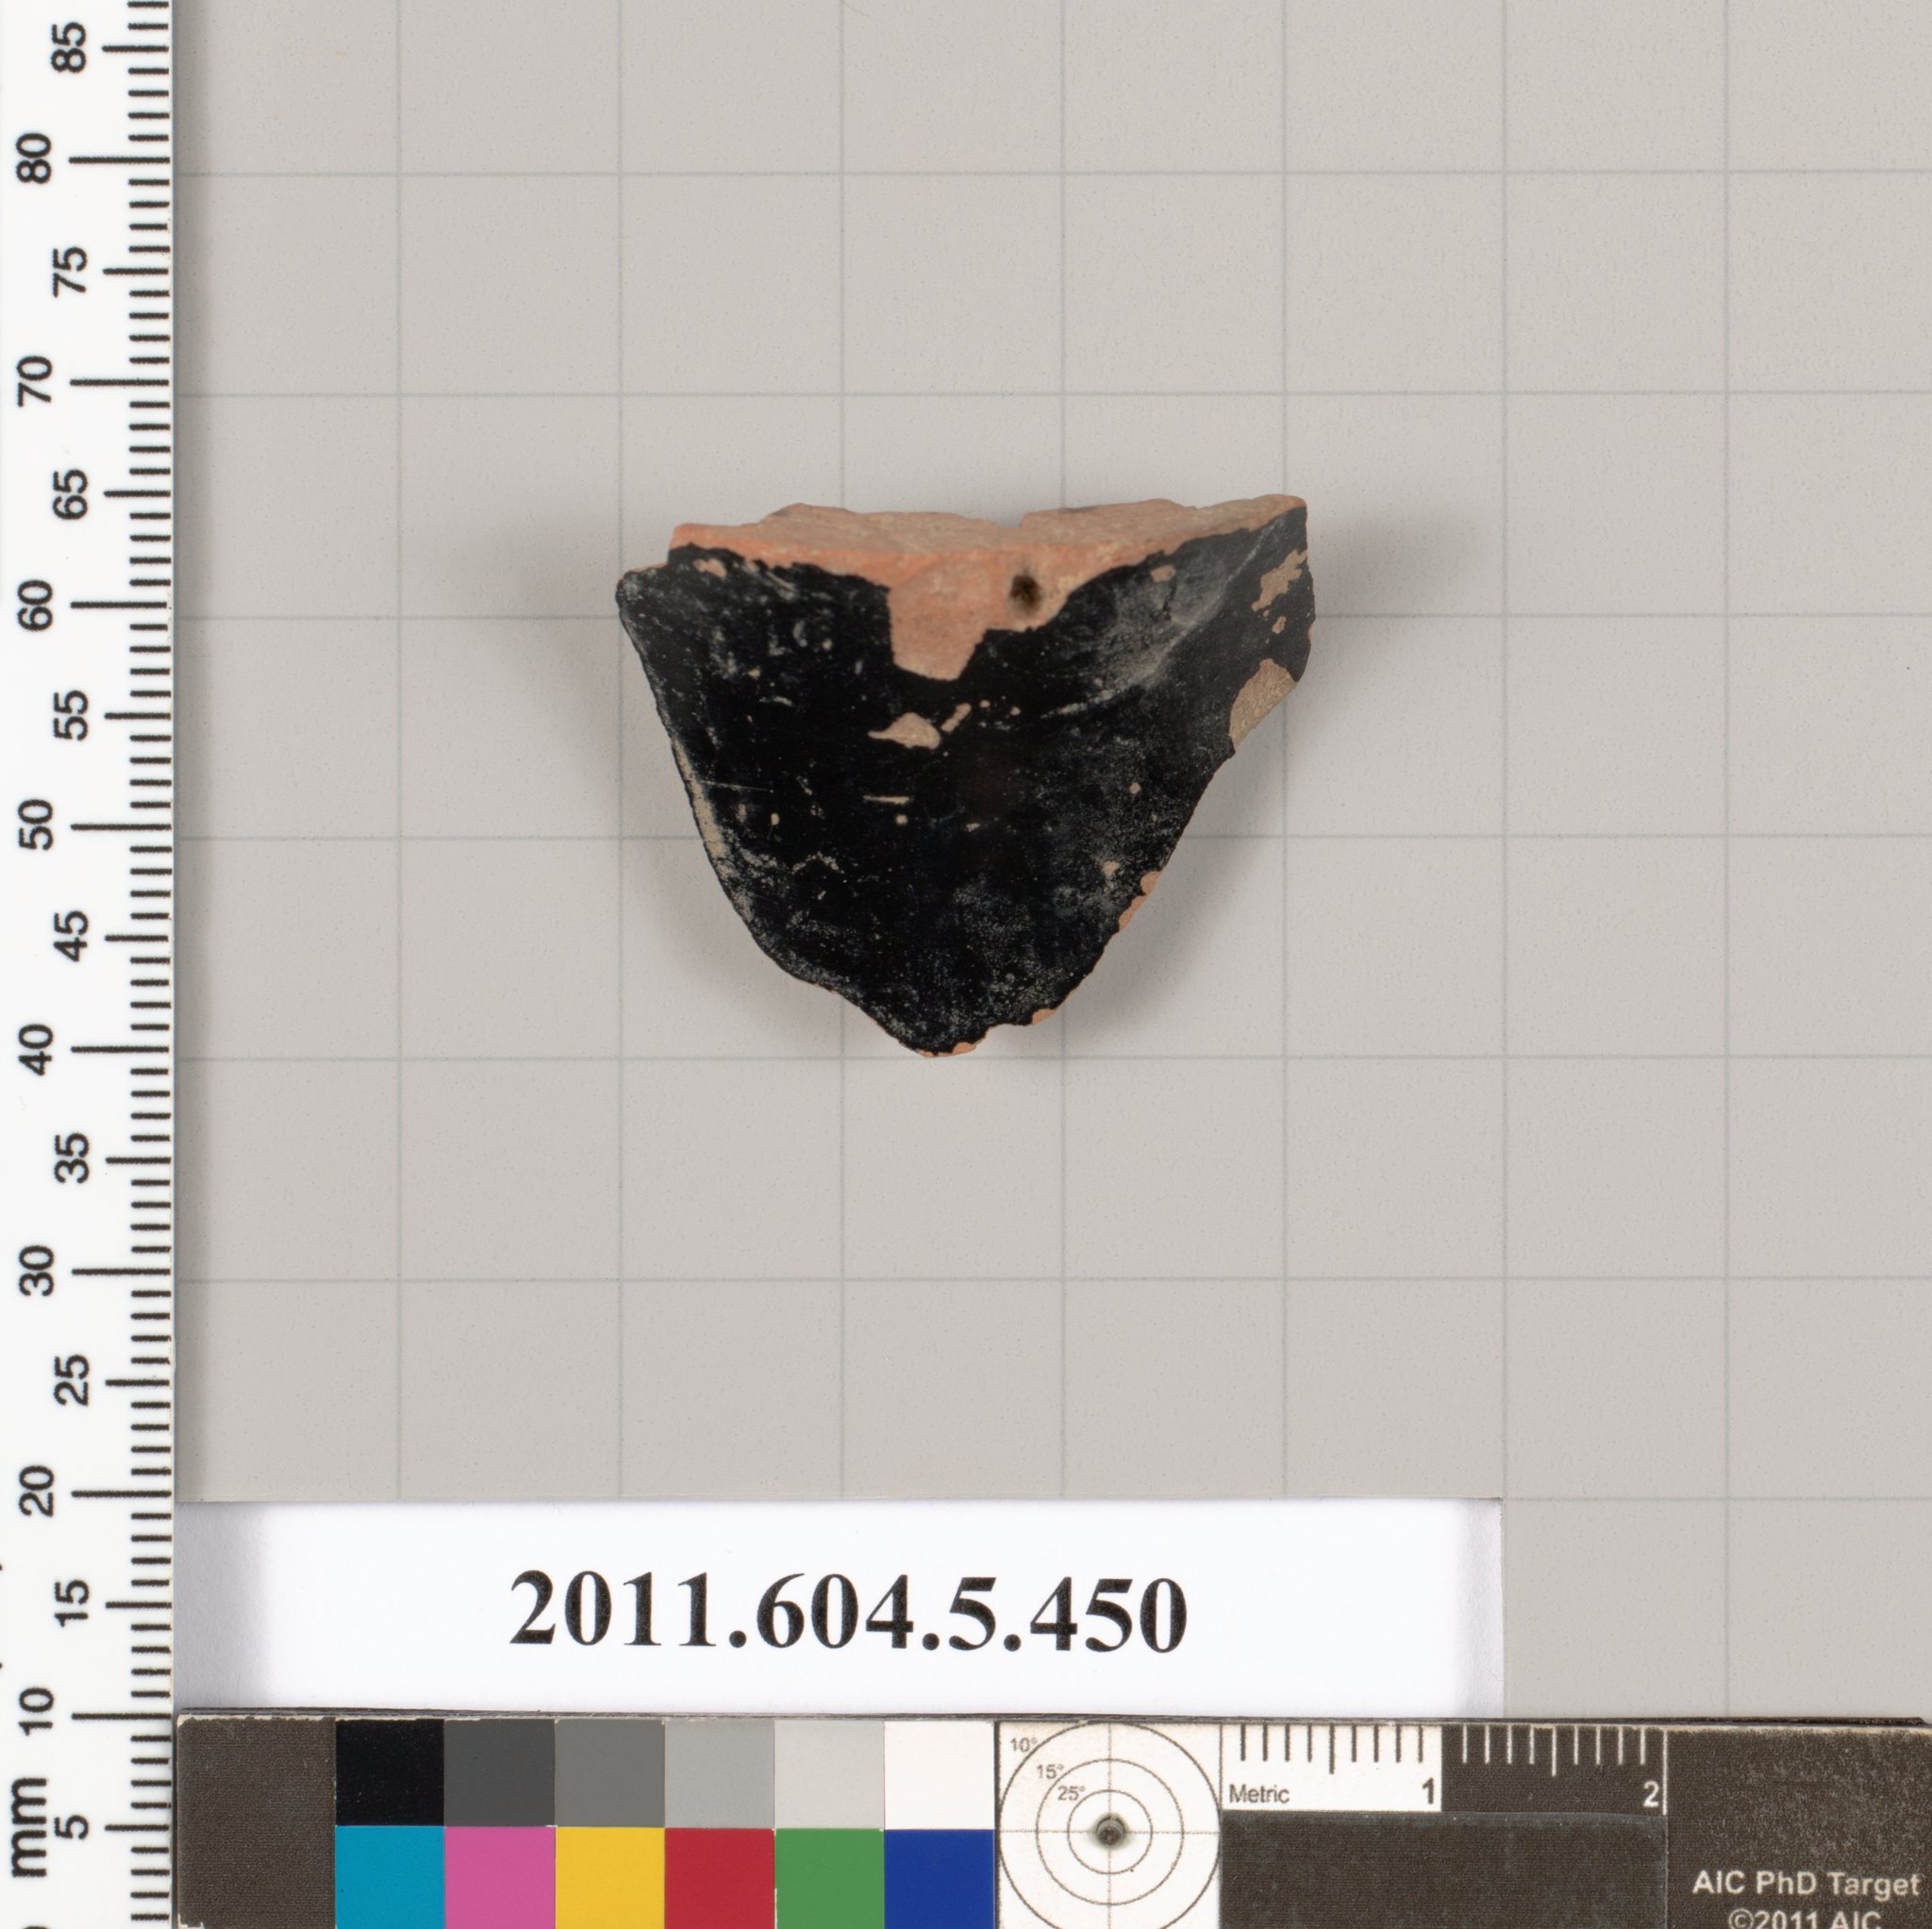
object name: kylix fragment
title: Terracotta fragment of a kylix (drinking cup)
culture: greek, attic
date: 600-401 BCE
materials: terracotta